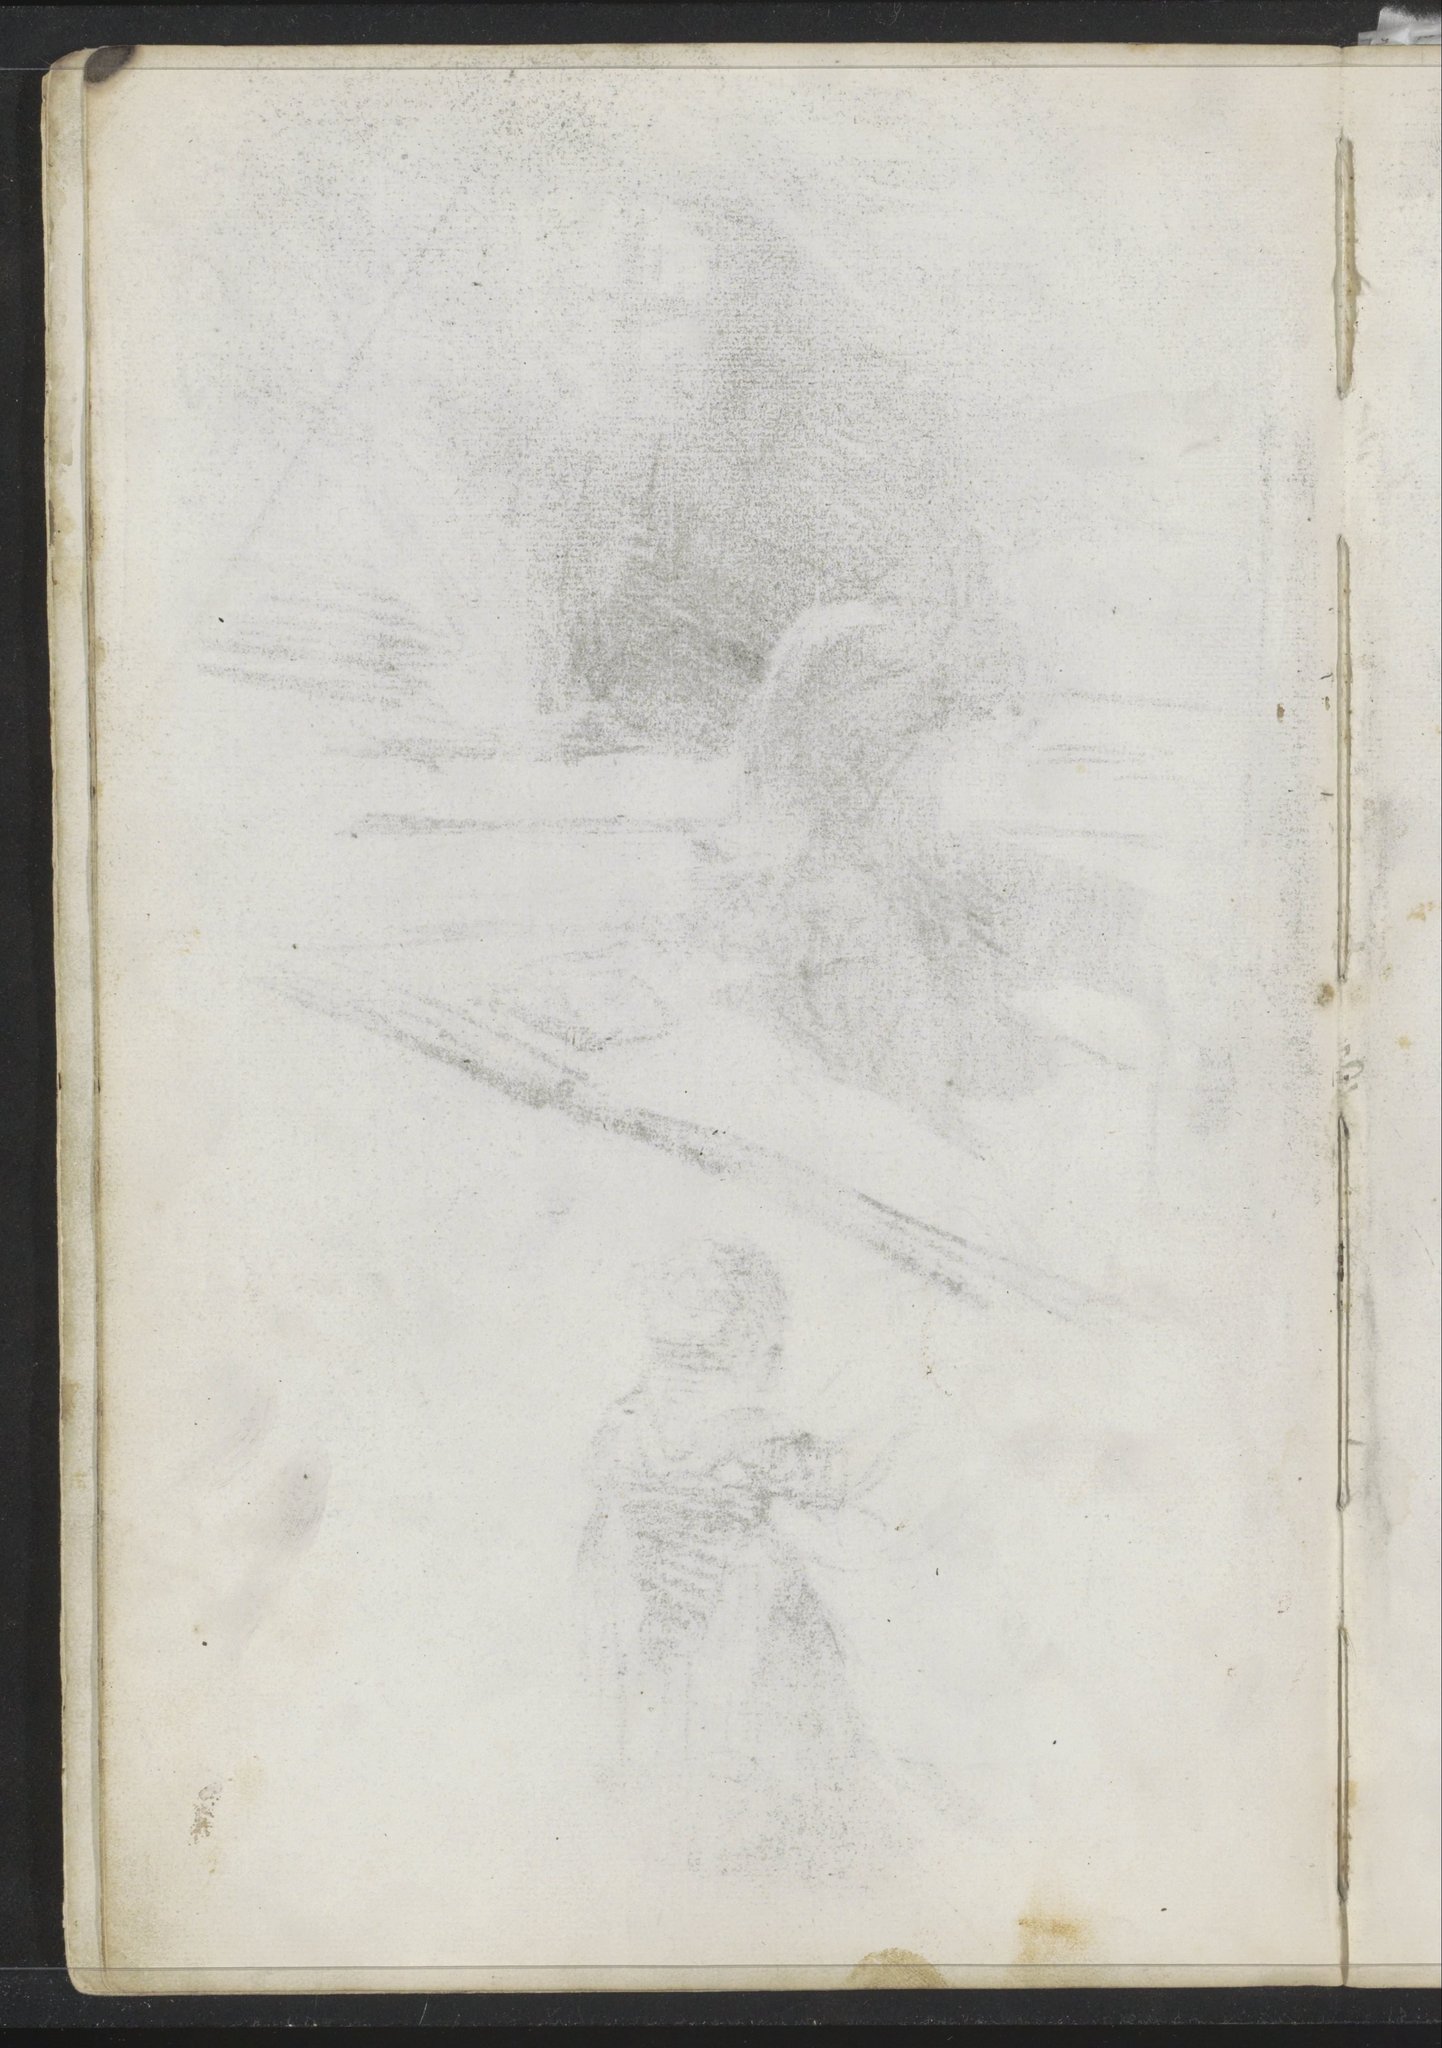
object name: sketchbook leaf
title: Abklatsch van een potloodtekening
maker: jozef israëls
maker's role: draughtsman, painter, print maker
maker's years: 1824-1911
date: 1855-1859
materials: paper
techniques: printmaking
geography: zandvoort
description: De tekeningen, waaronder één van een meisje, zijn niet langer aanwezig in het schetsboek. Blad 6 verso uit een schetsboek met 22 bladen.